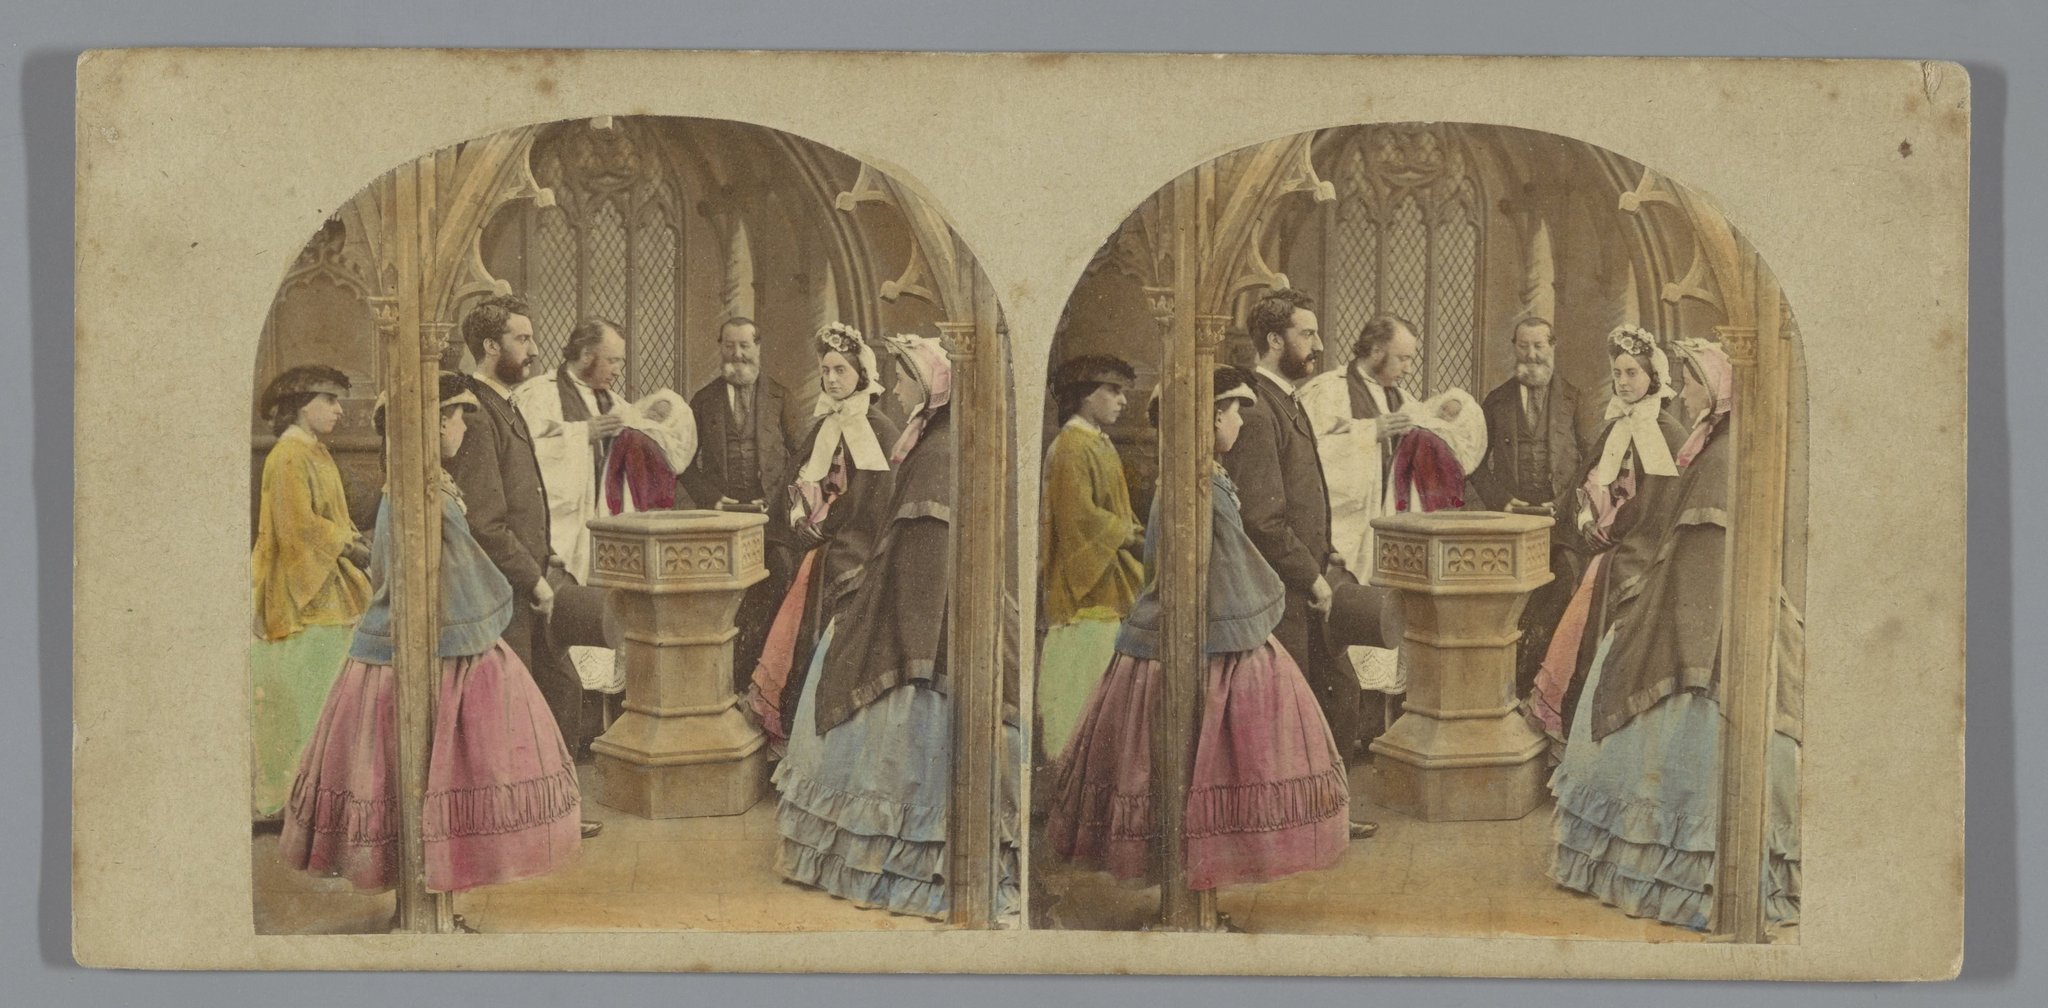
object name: stereograph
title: Doop van een kind in een kerk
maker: Anonymous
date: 1852-1863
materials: cardboard, paper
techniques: albumen print, hand coloring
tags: baptism, christening ceremony ~ the first of the seven sacraments, parts of church interior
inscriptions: retailer's mark: ‘[...]’